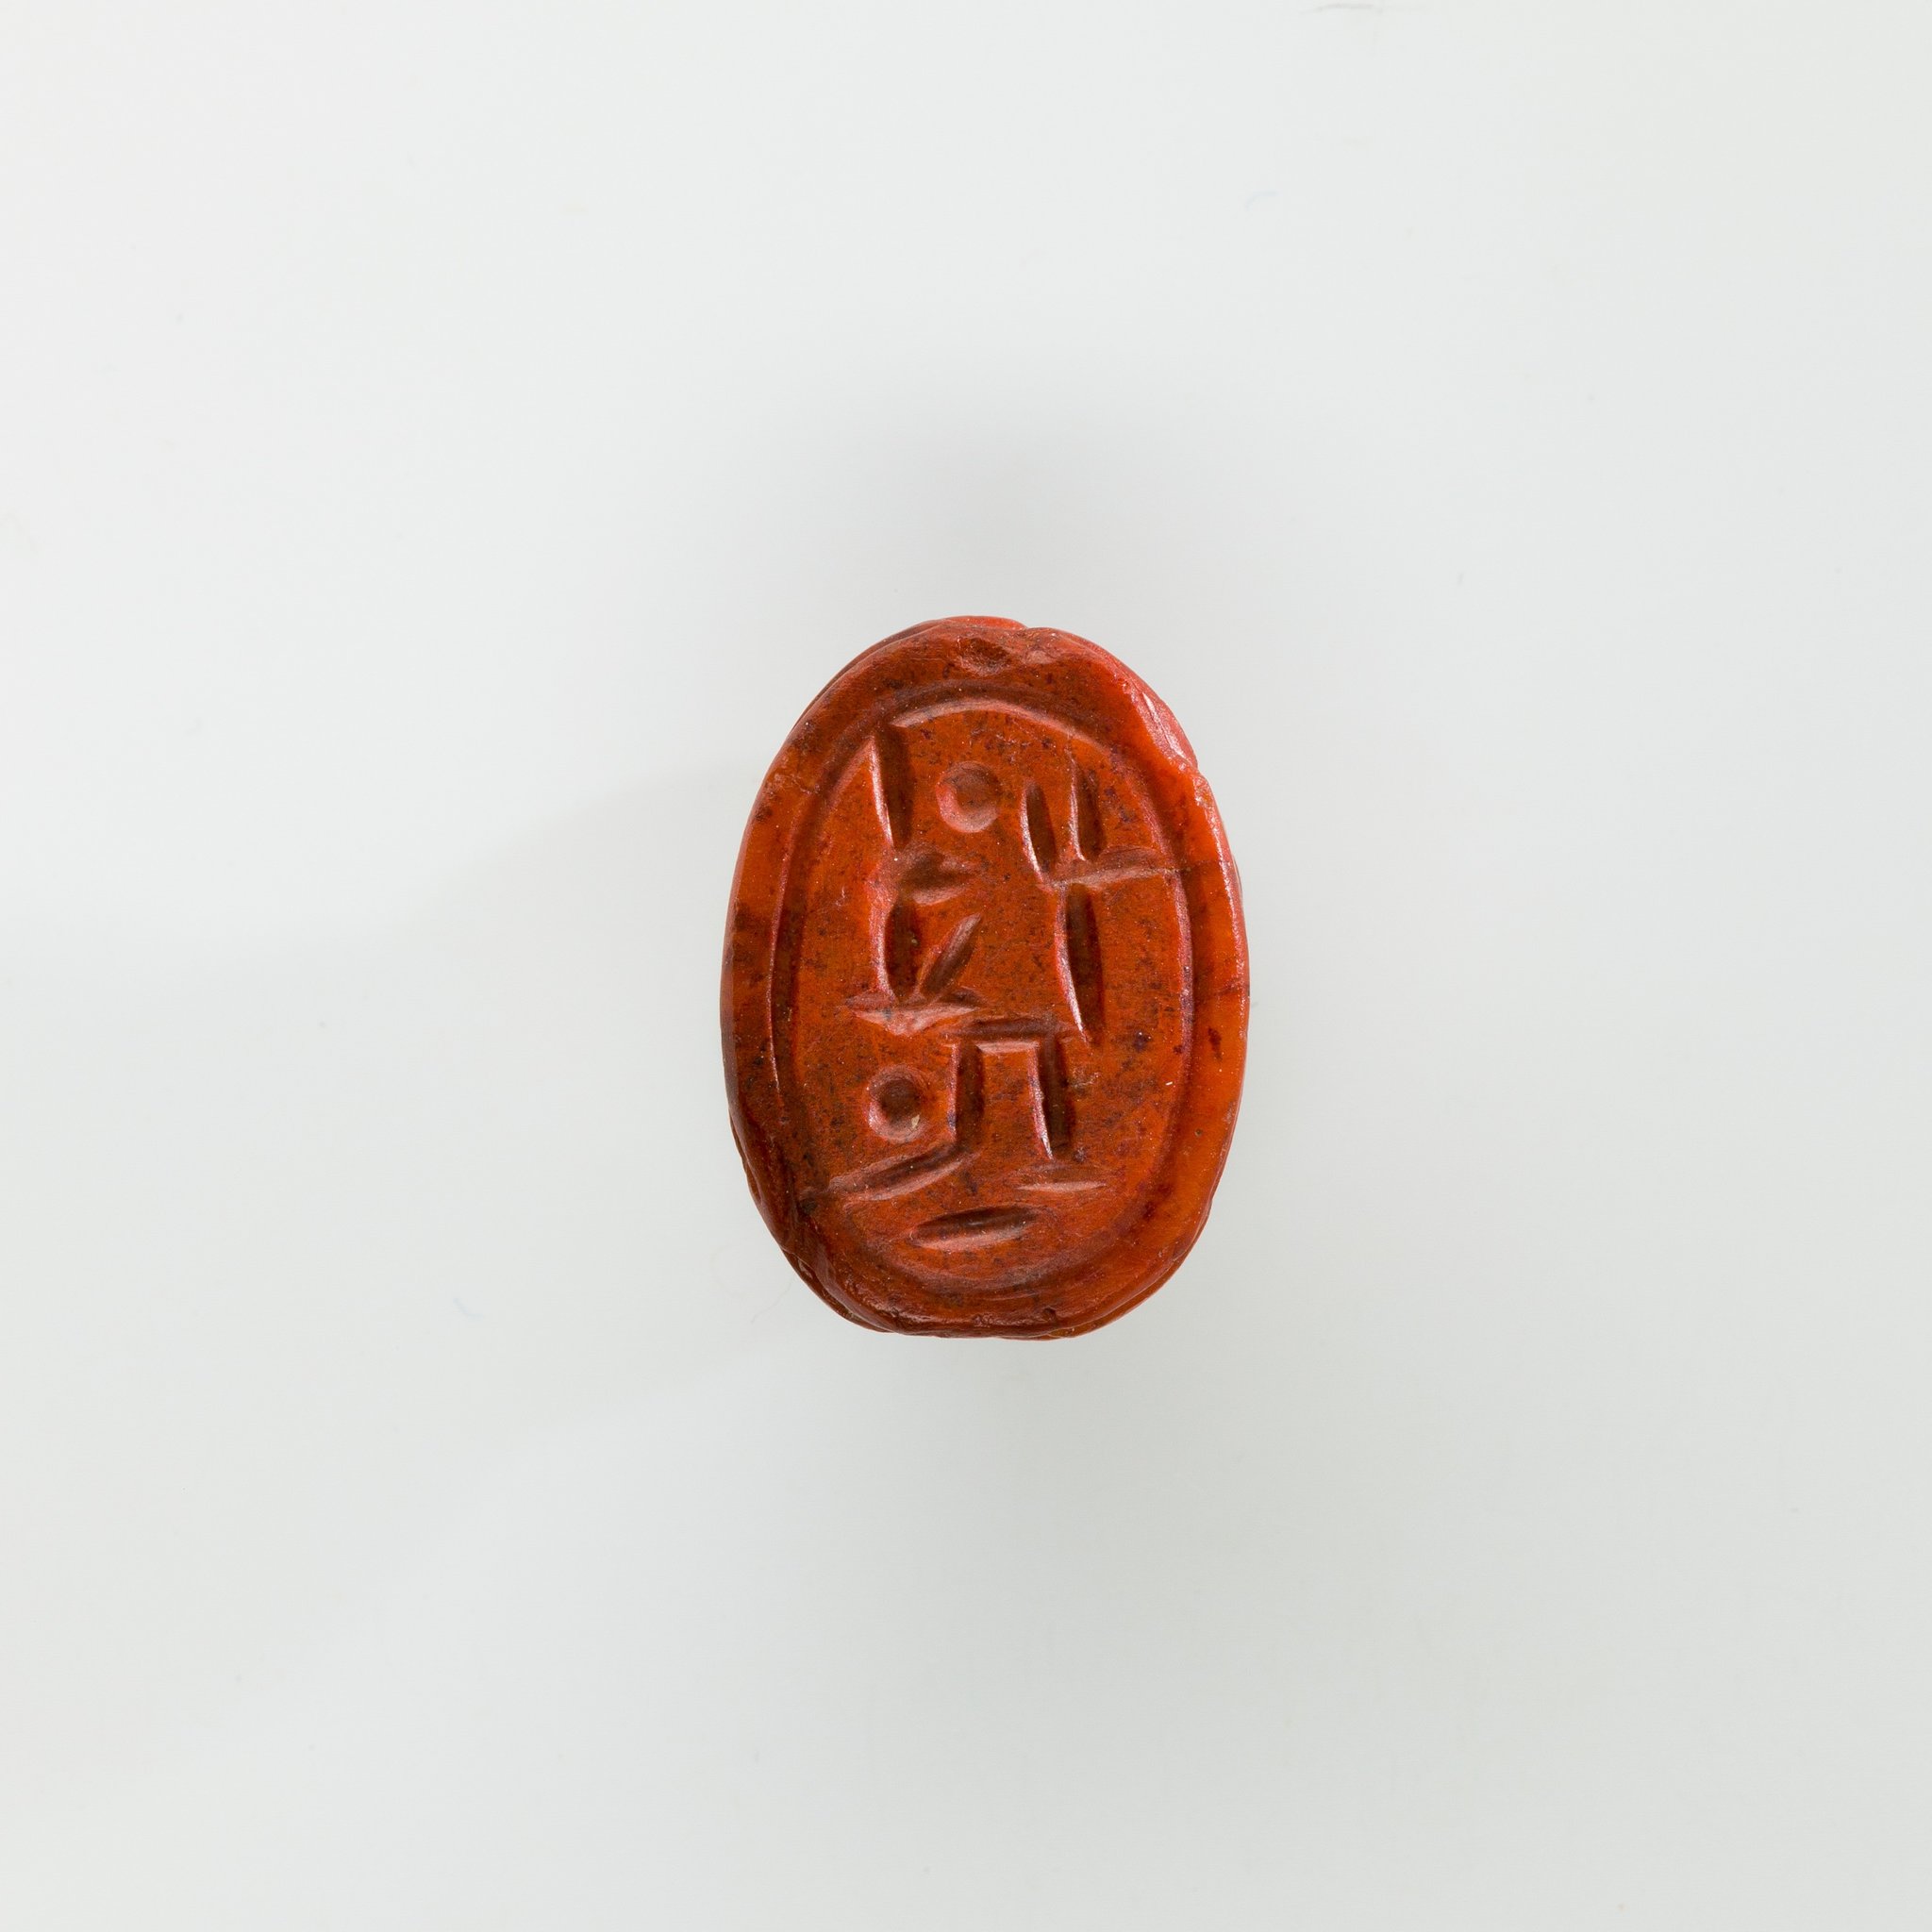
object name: scarab, ramesses ii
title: Scarab of Ramesses II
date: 1295-1070 BCE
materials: jasper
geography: egypt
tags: hieroglyphs,scarabs